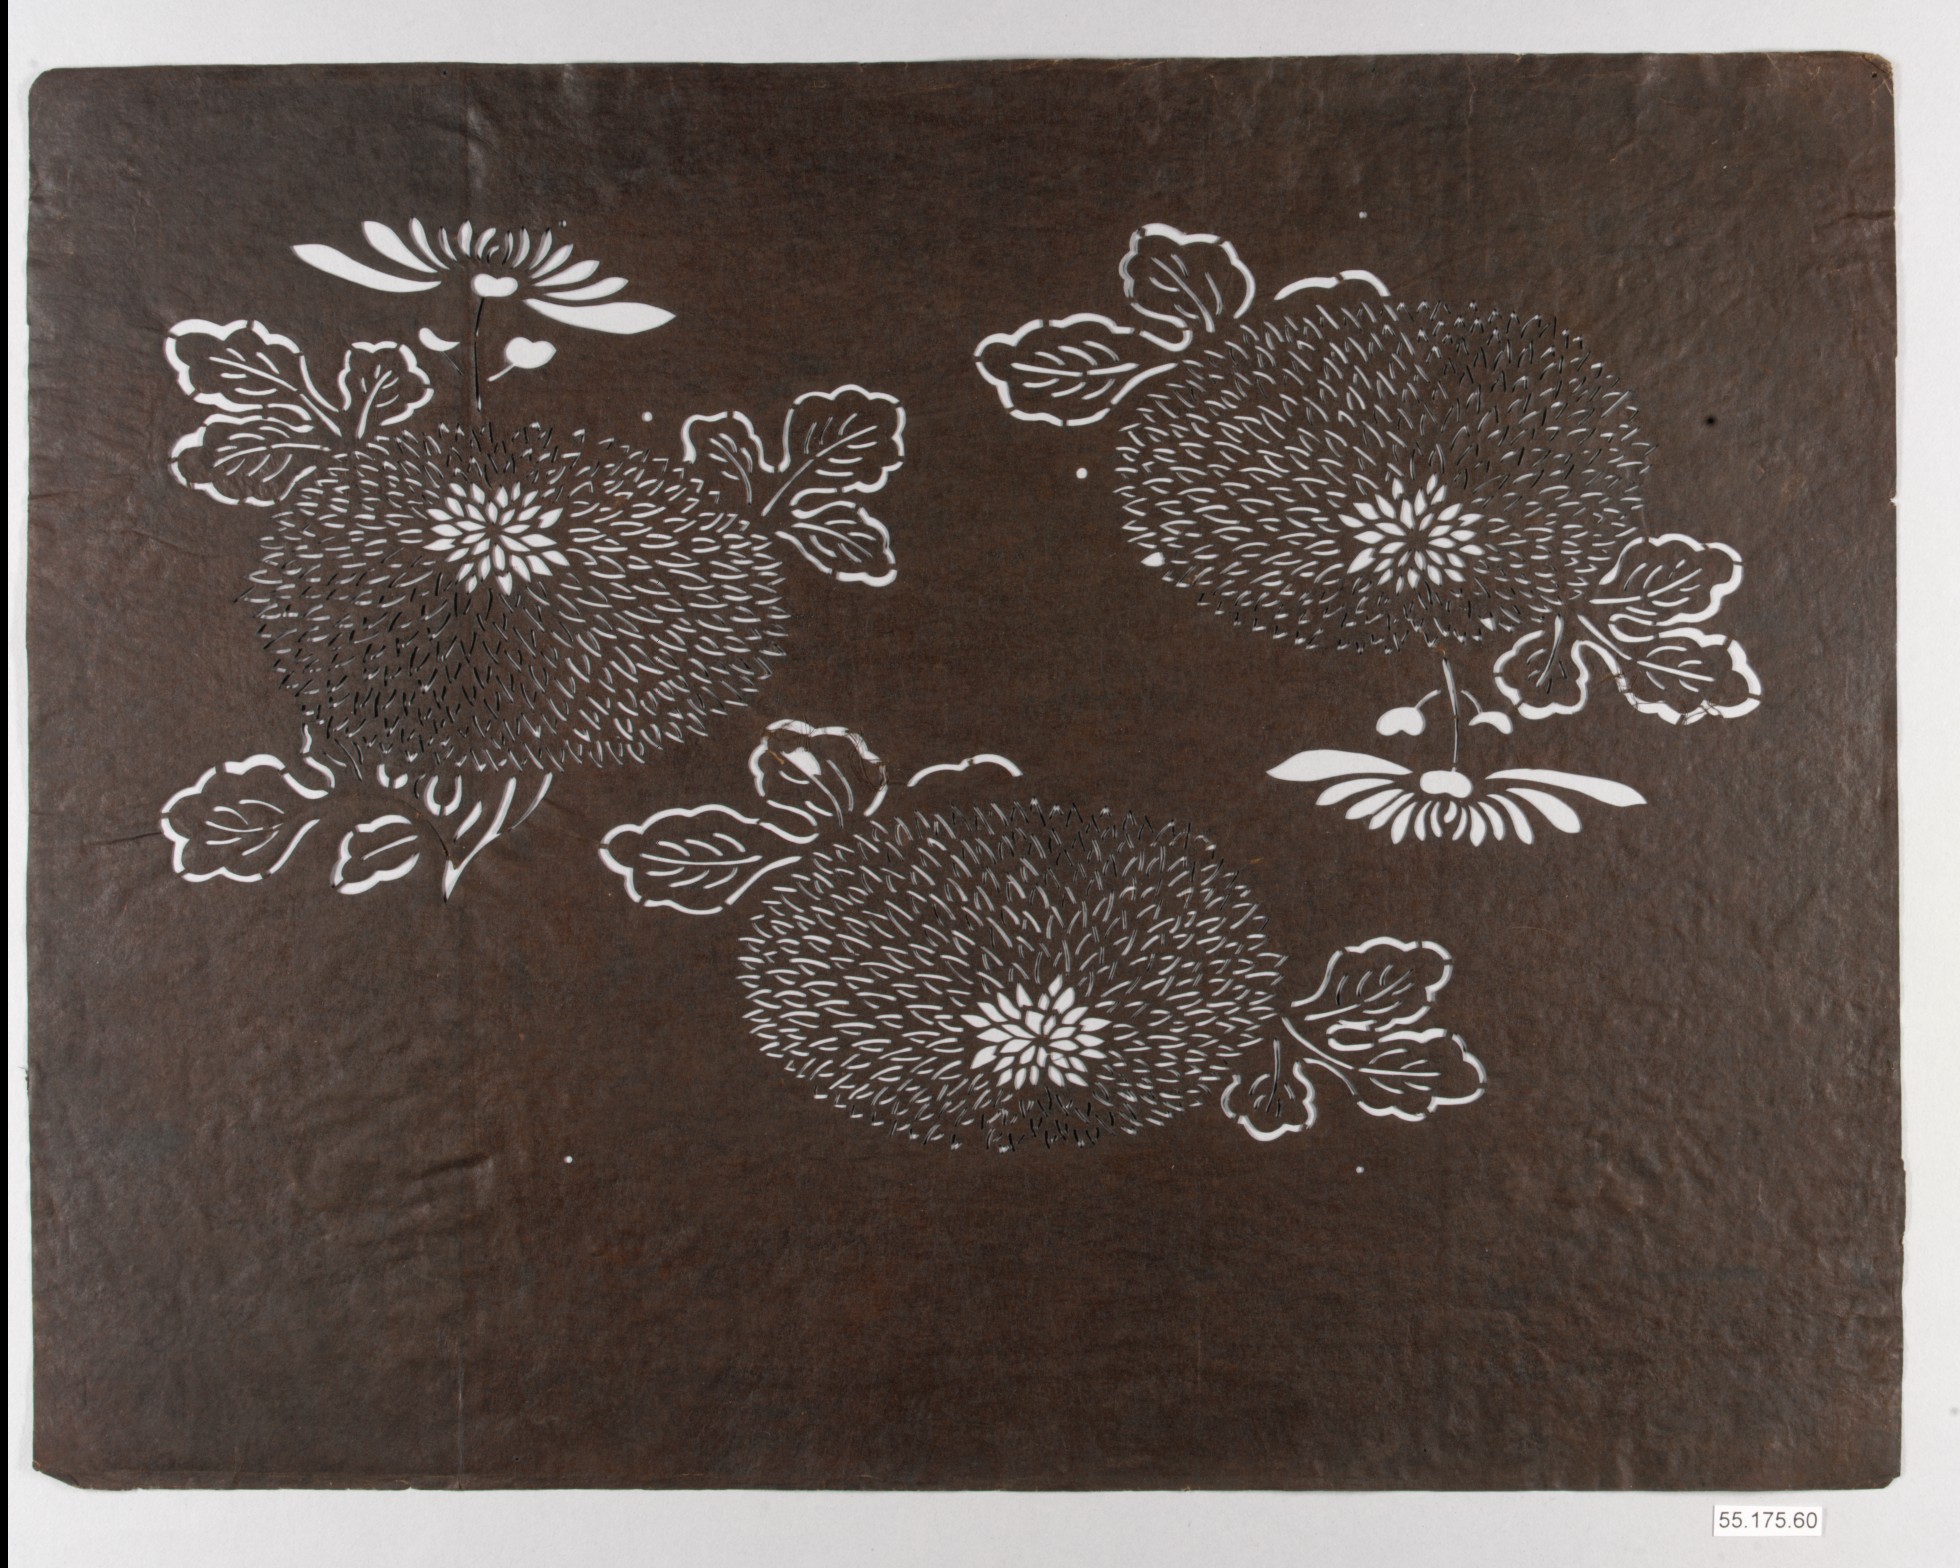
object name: stencil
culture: japanese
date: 1801-1900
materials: paper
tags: flowers